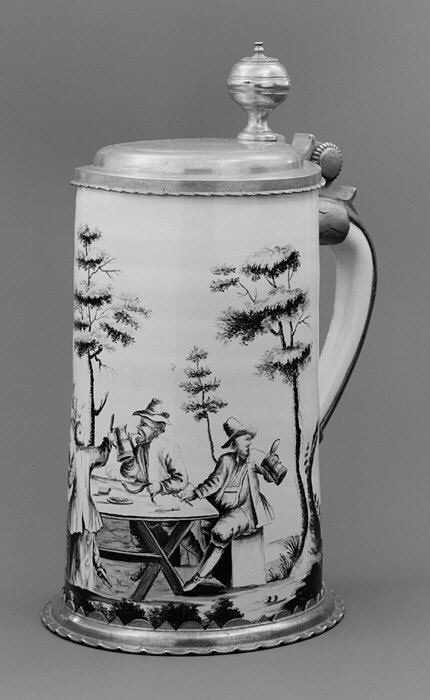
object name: tankard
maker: matthias smid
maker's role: enameler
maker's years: 1675-1775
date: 1720-1730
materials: earthenware, pewter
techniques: glazing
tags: men,trees,drinking